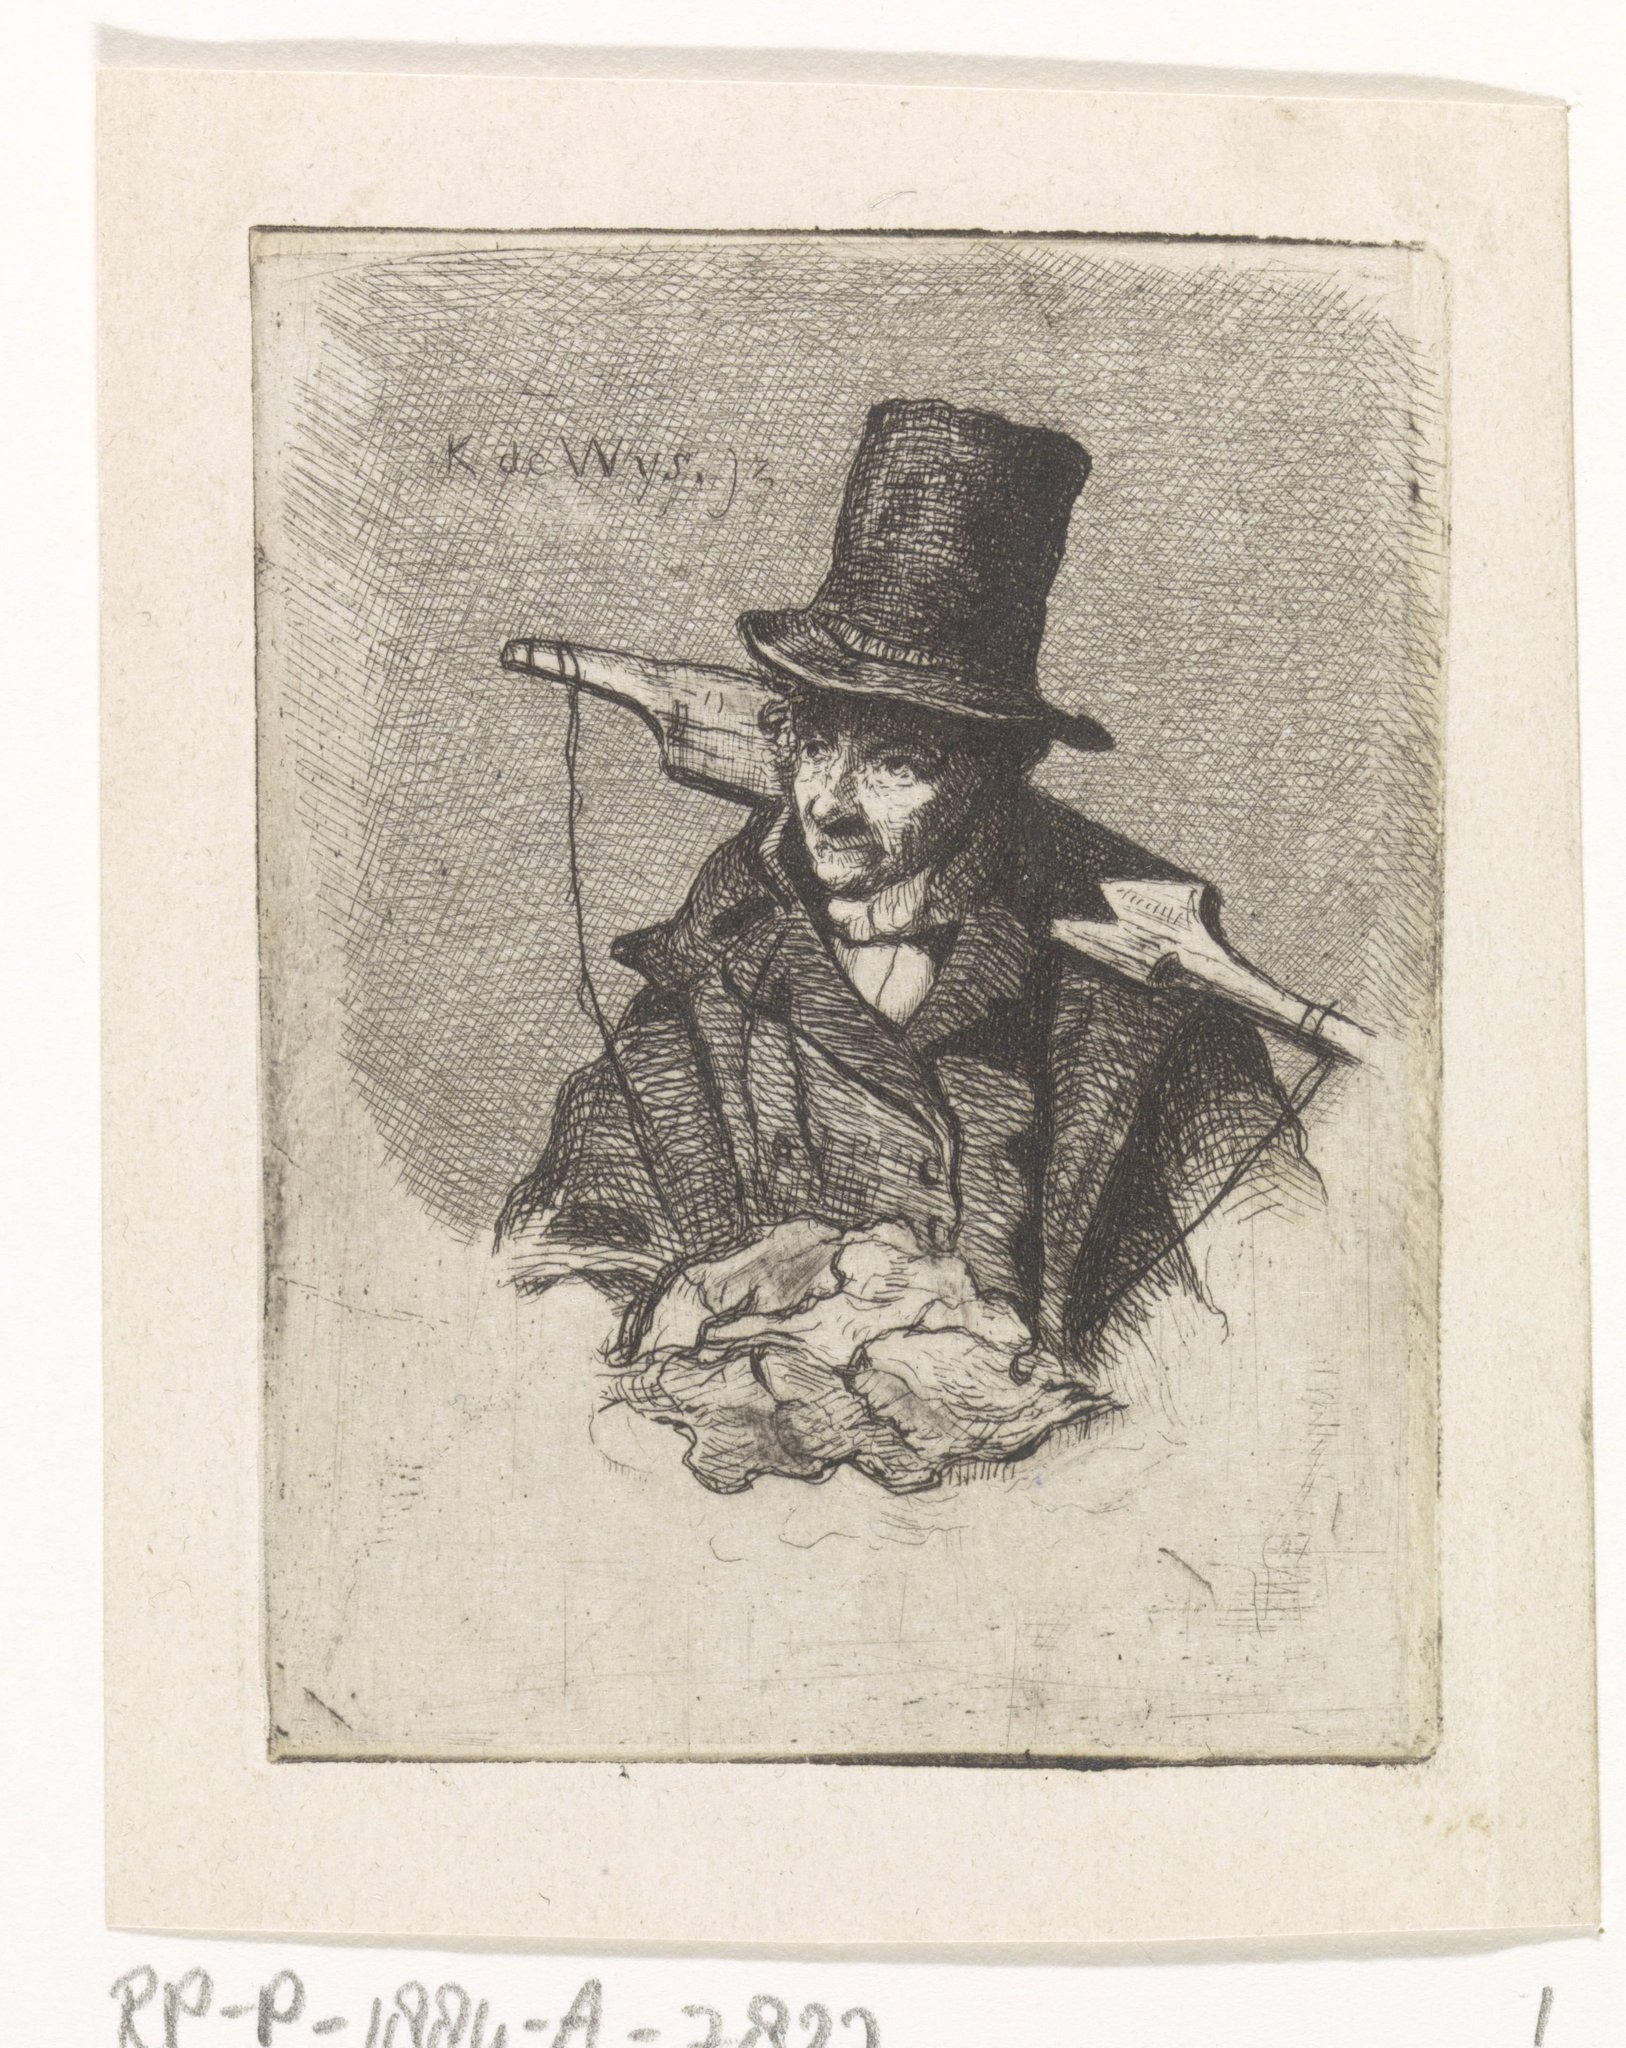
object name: print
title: Koopman met een juk op de schouders en een bloemkool voor zich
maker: kornelis jzn de wijs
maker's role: print maker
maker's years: 1832-1896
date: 1842-1884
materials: paper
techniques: etching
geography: netherlands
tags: vegetables, yoke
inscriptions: collector's mark: Lugt 2228